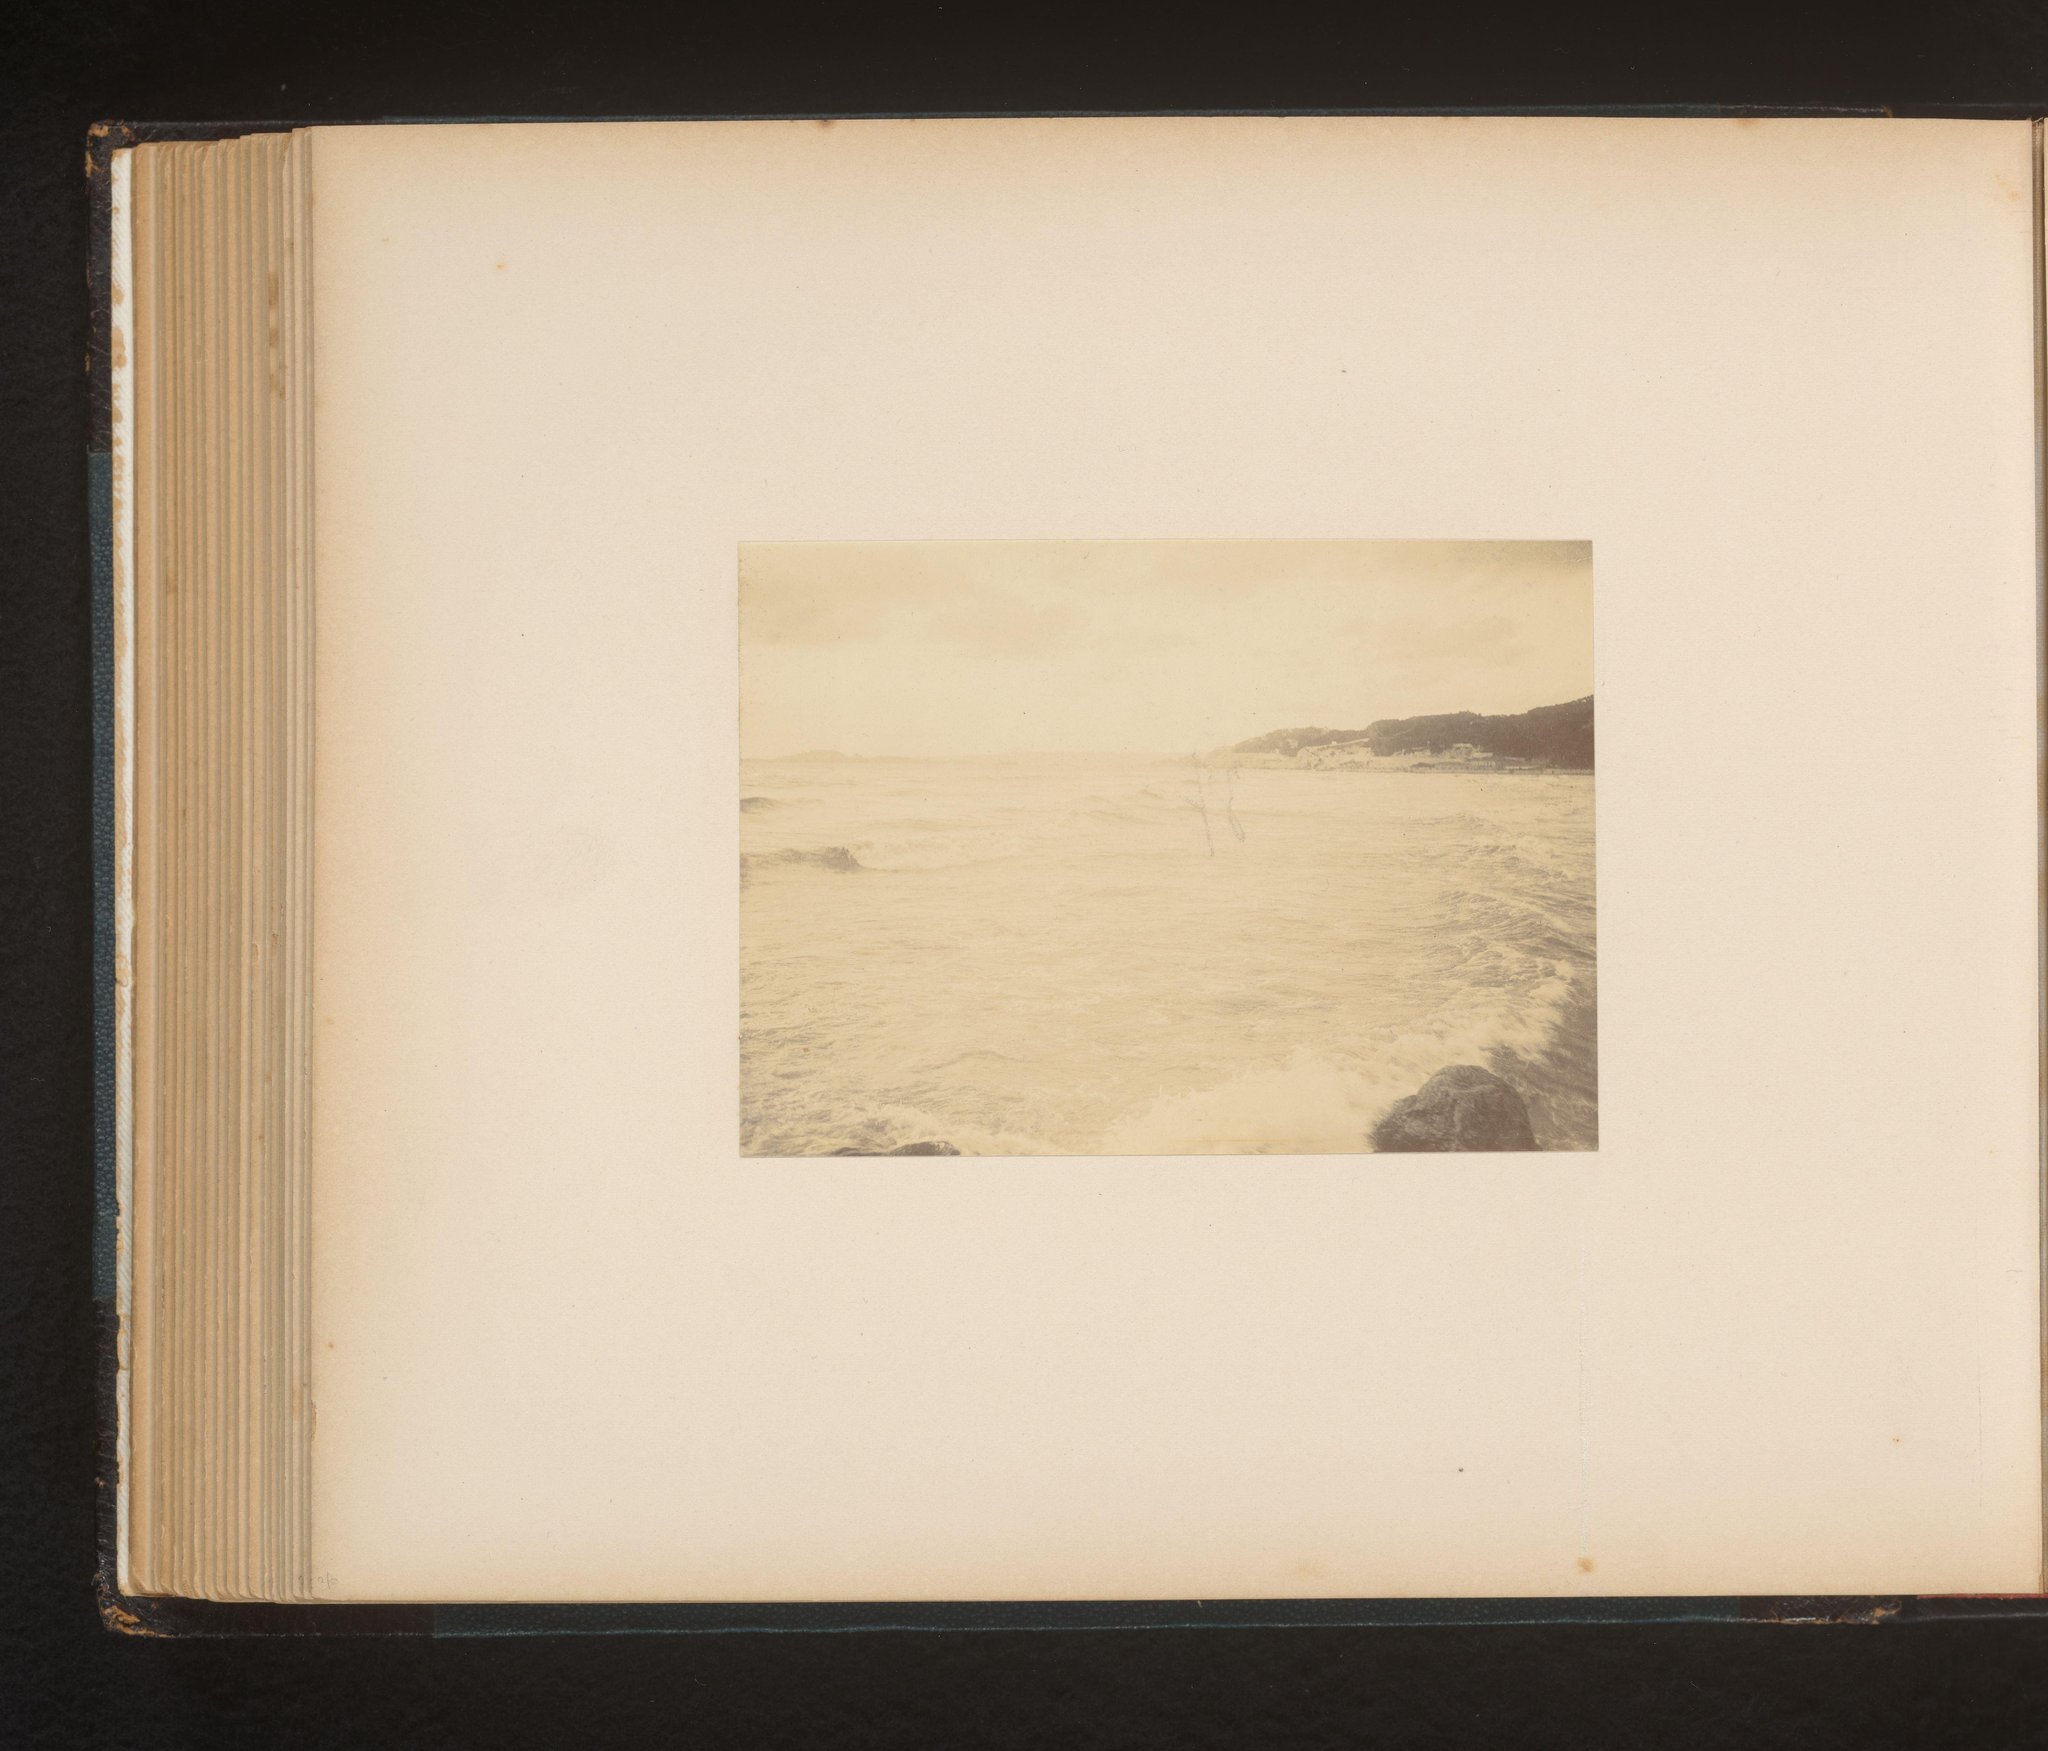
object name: album leaf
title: Gezicht op een kust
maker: Anonymous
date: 1880-1920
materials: cardboard, photographic support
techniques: gelatin silver print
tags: coast, france